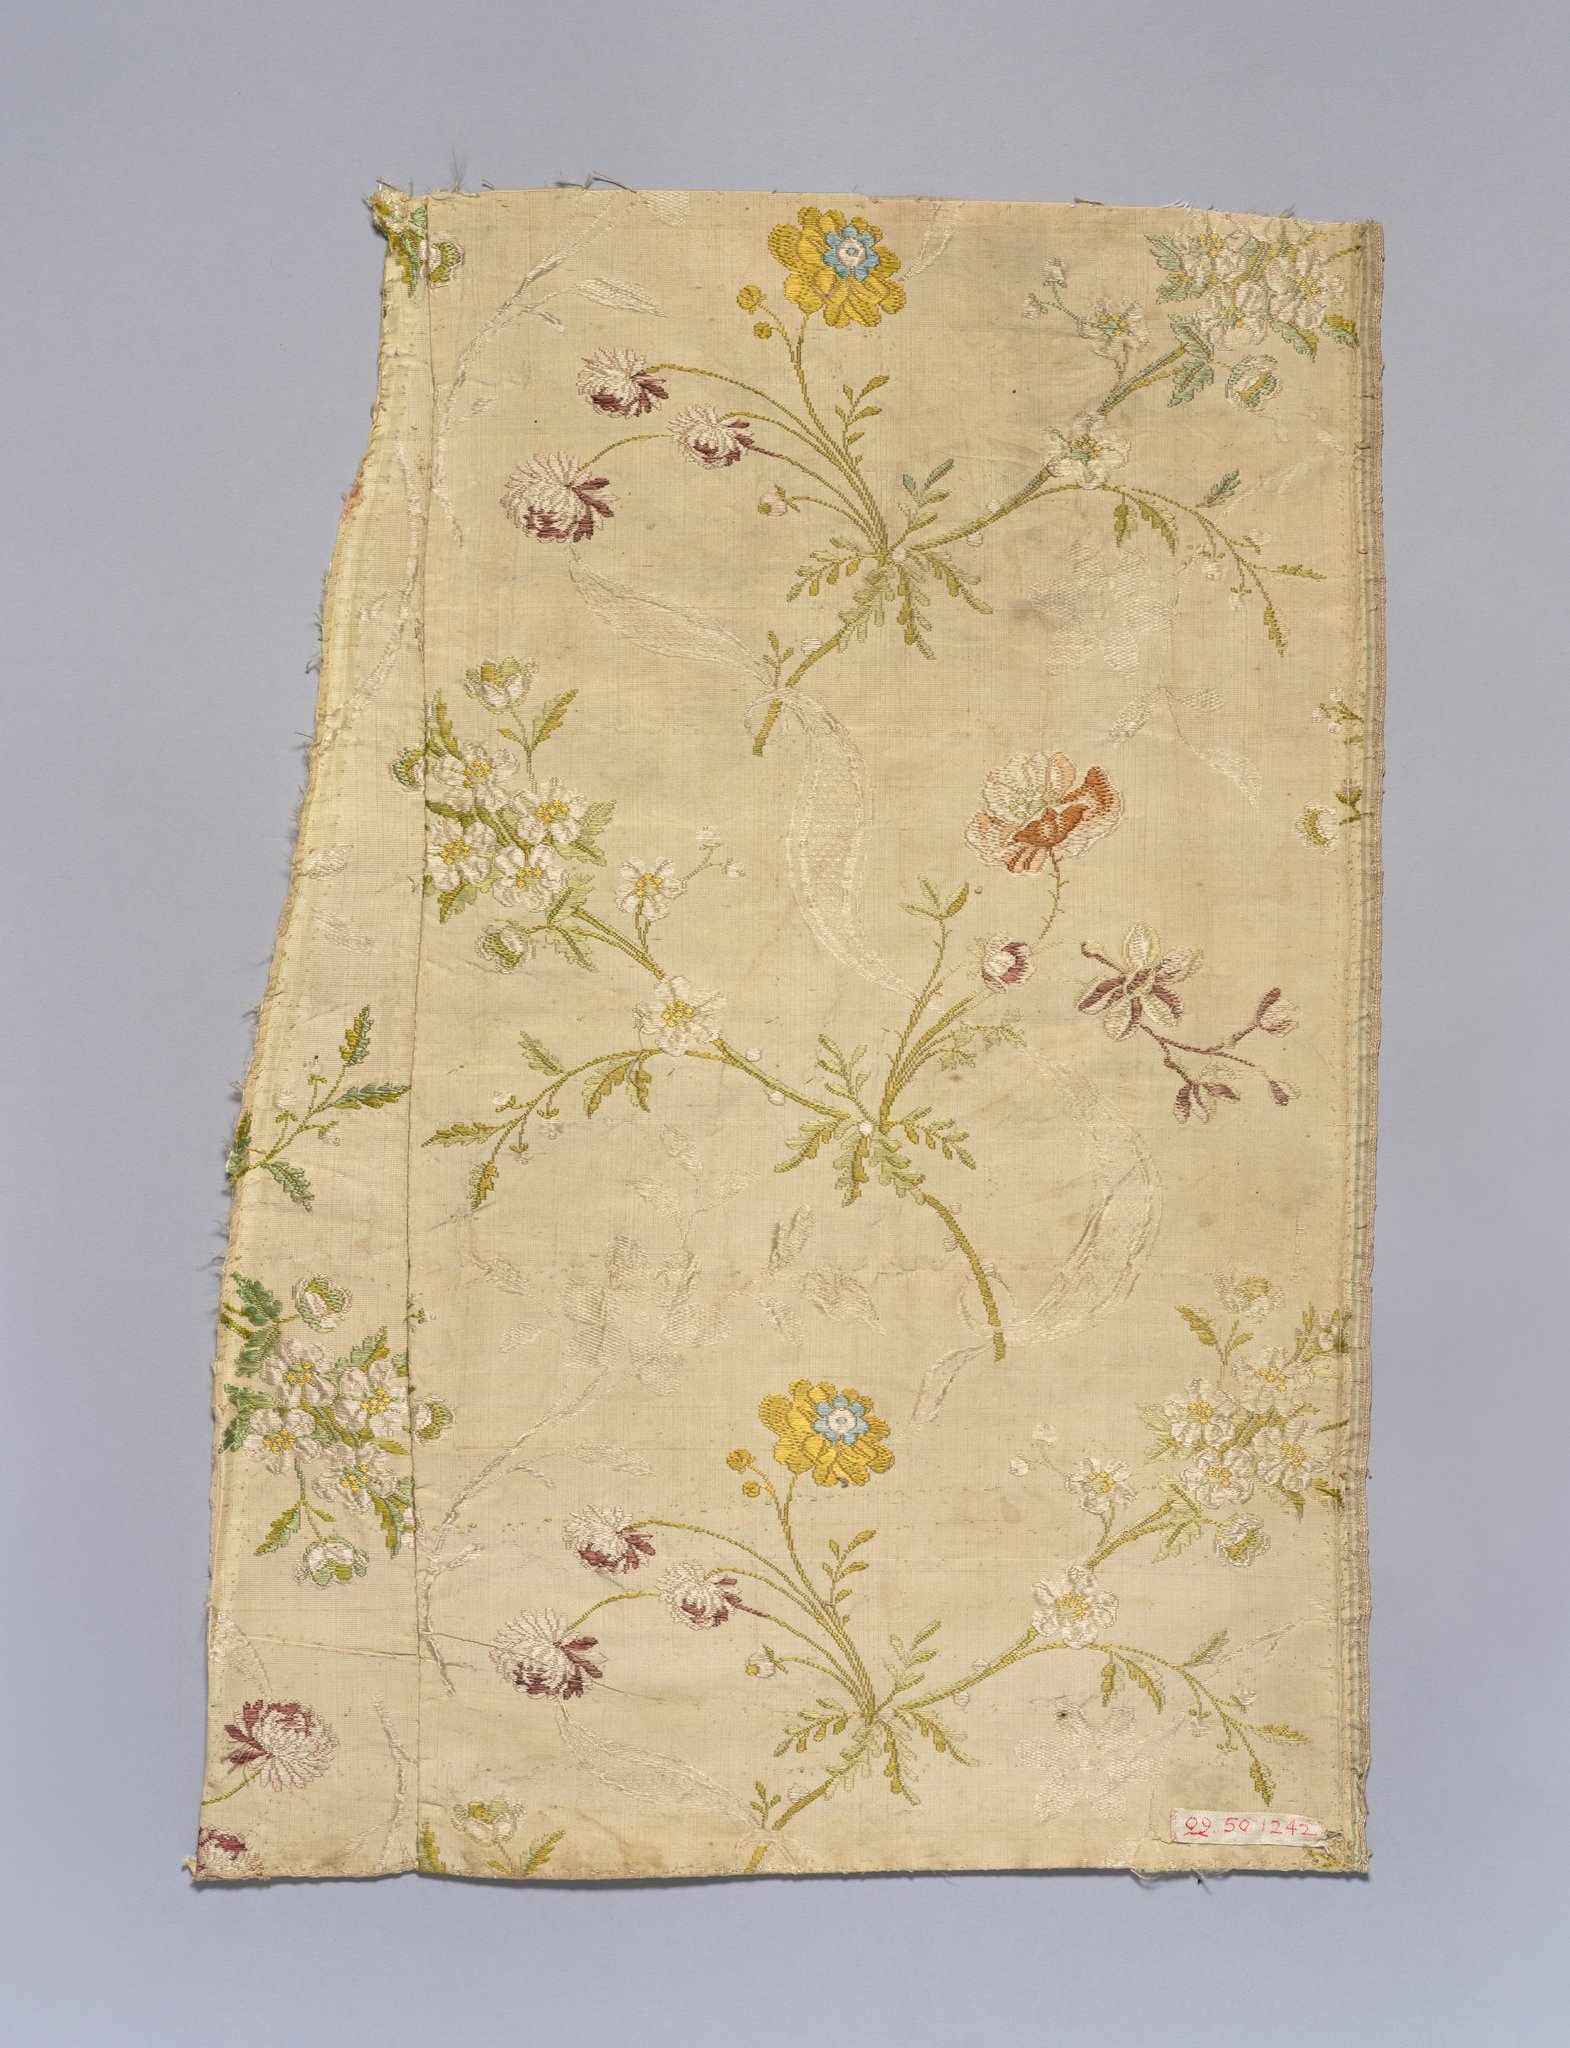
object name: piece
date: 1750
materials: silk